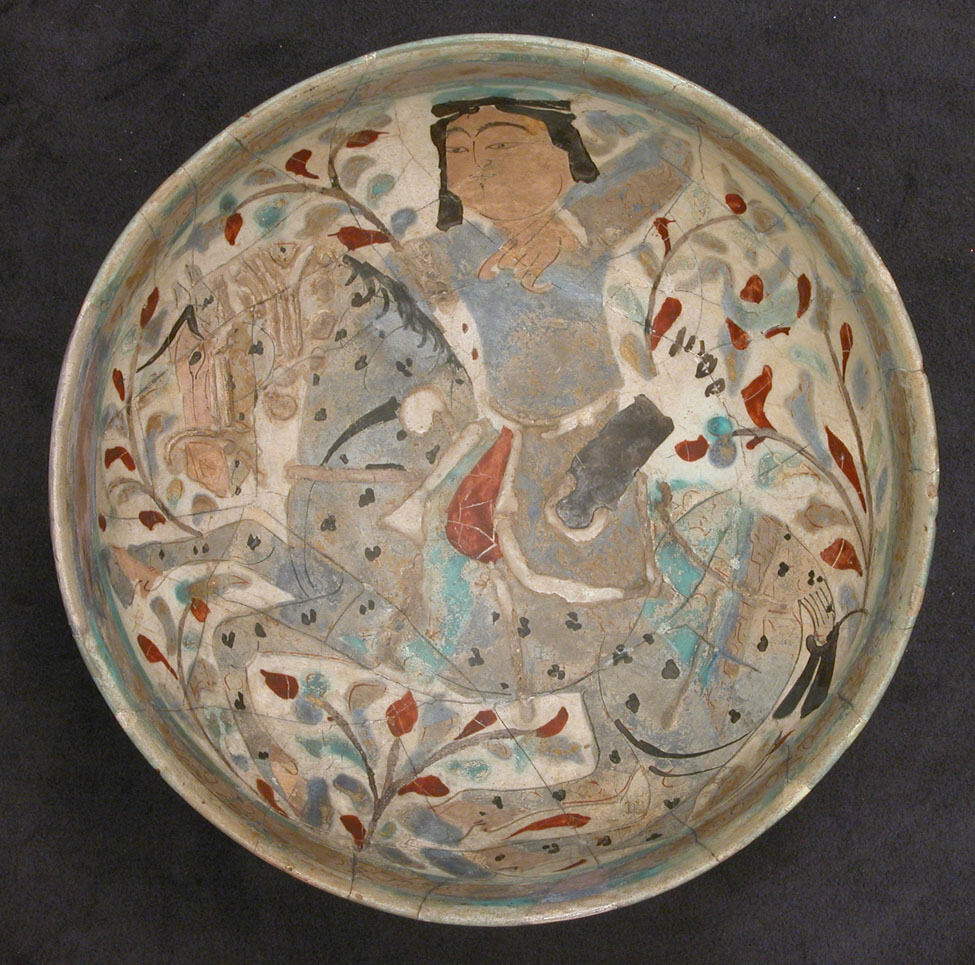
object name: bowl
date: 1101-1300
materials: stonepaste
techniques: overglaze, painting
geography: iran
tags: horses